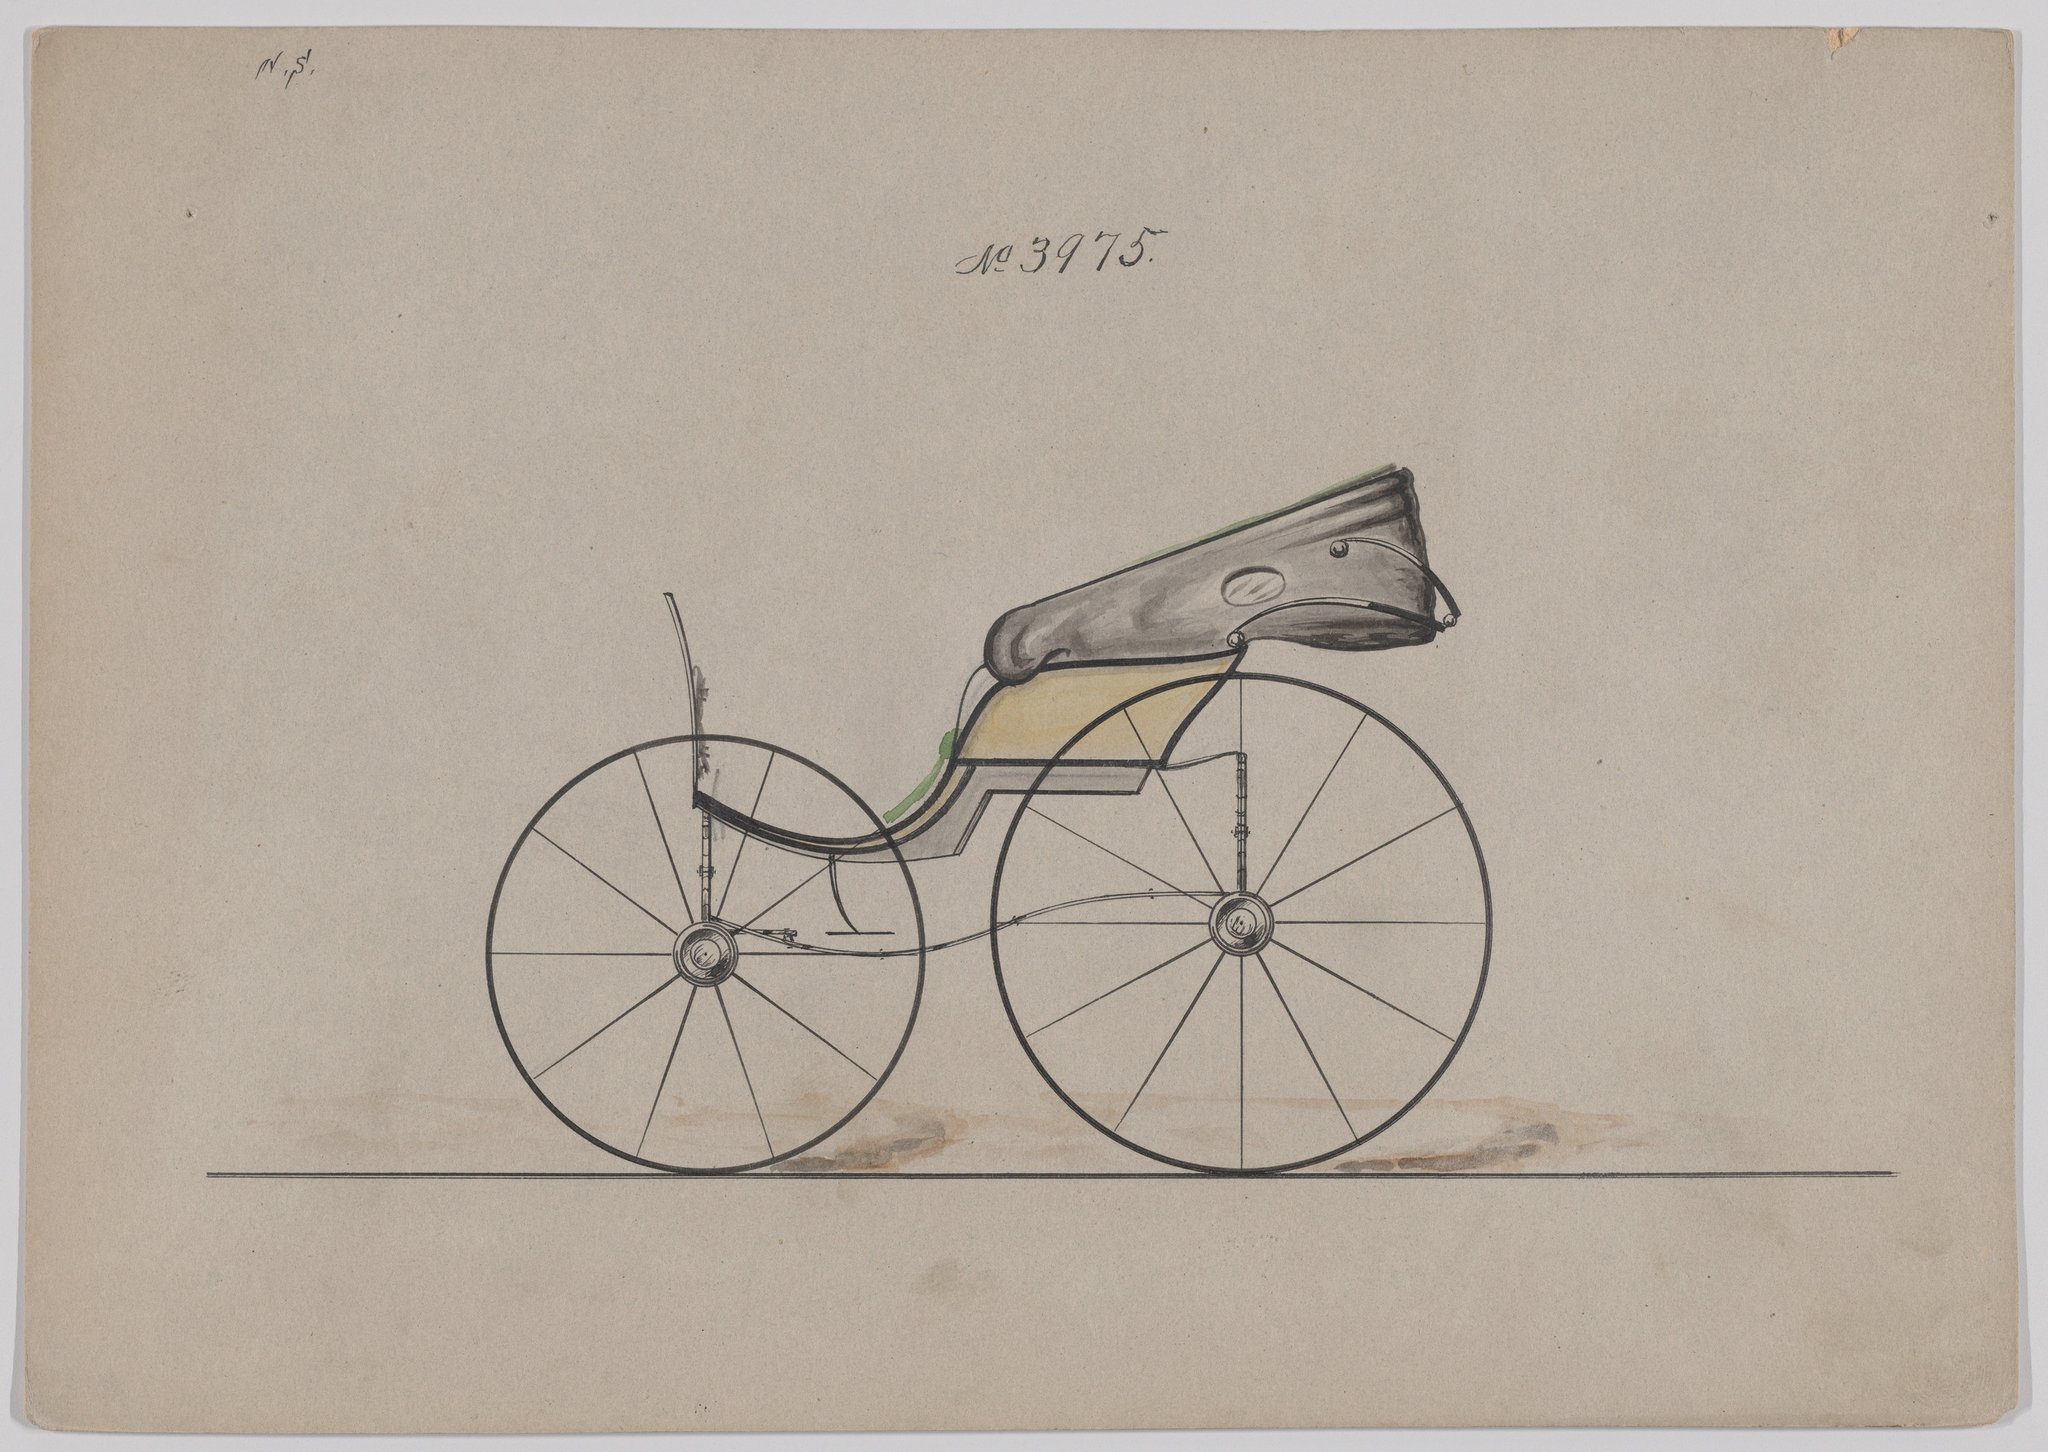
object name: drawing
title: Design for Pony Phaeton, no. 3975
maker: brewster & co.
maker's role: manufacturer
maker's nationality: american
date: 1886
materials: gouache, ink, watercolor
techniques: pen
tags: carriages